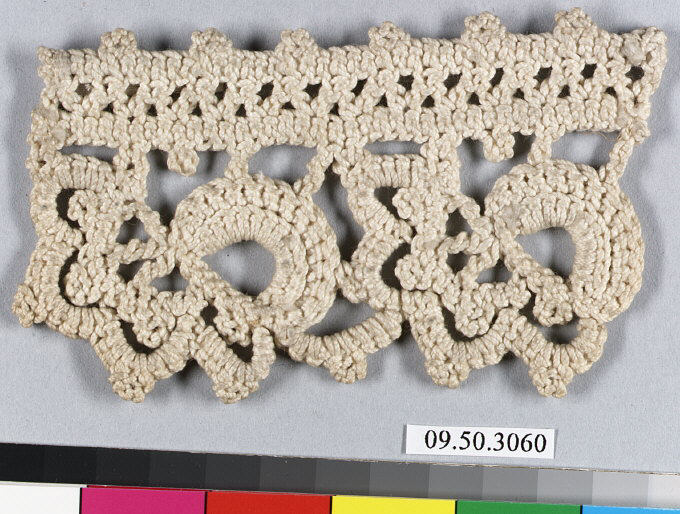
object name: sample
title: Crochet Work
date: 1801-1900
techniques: crochet